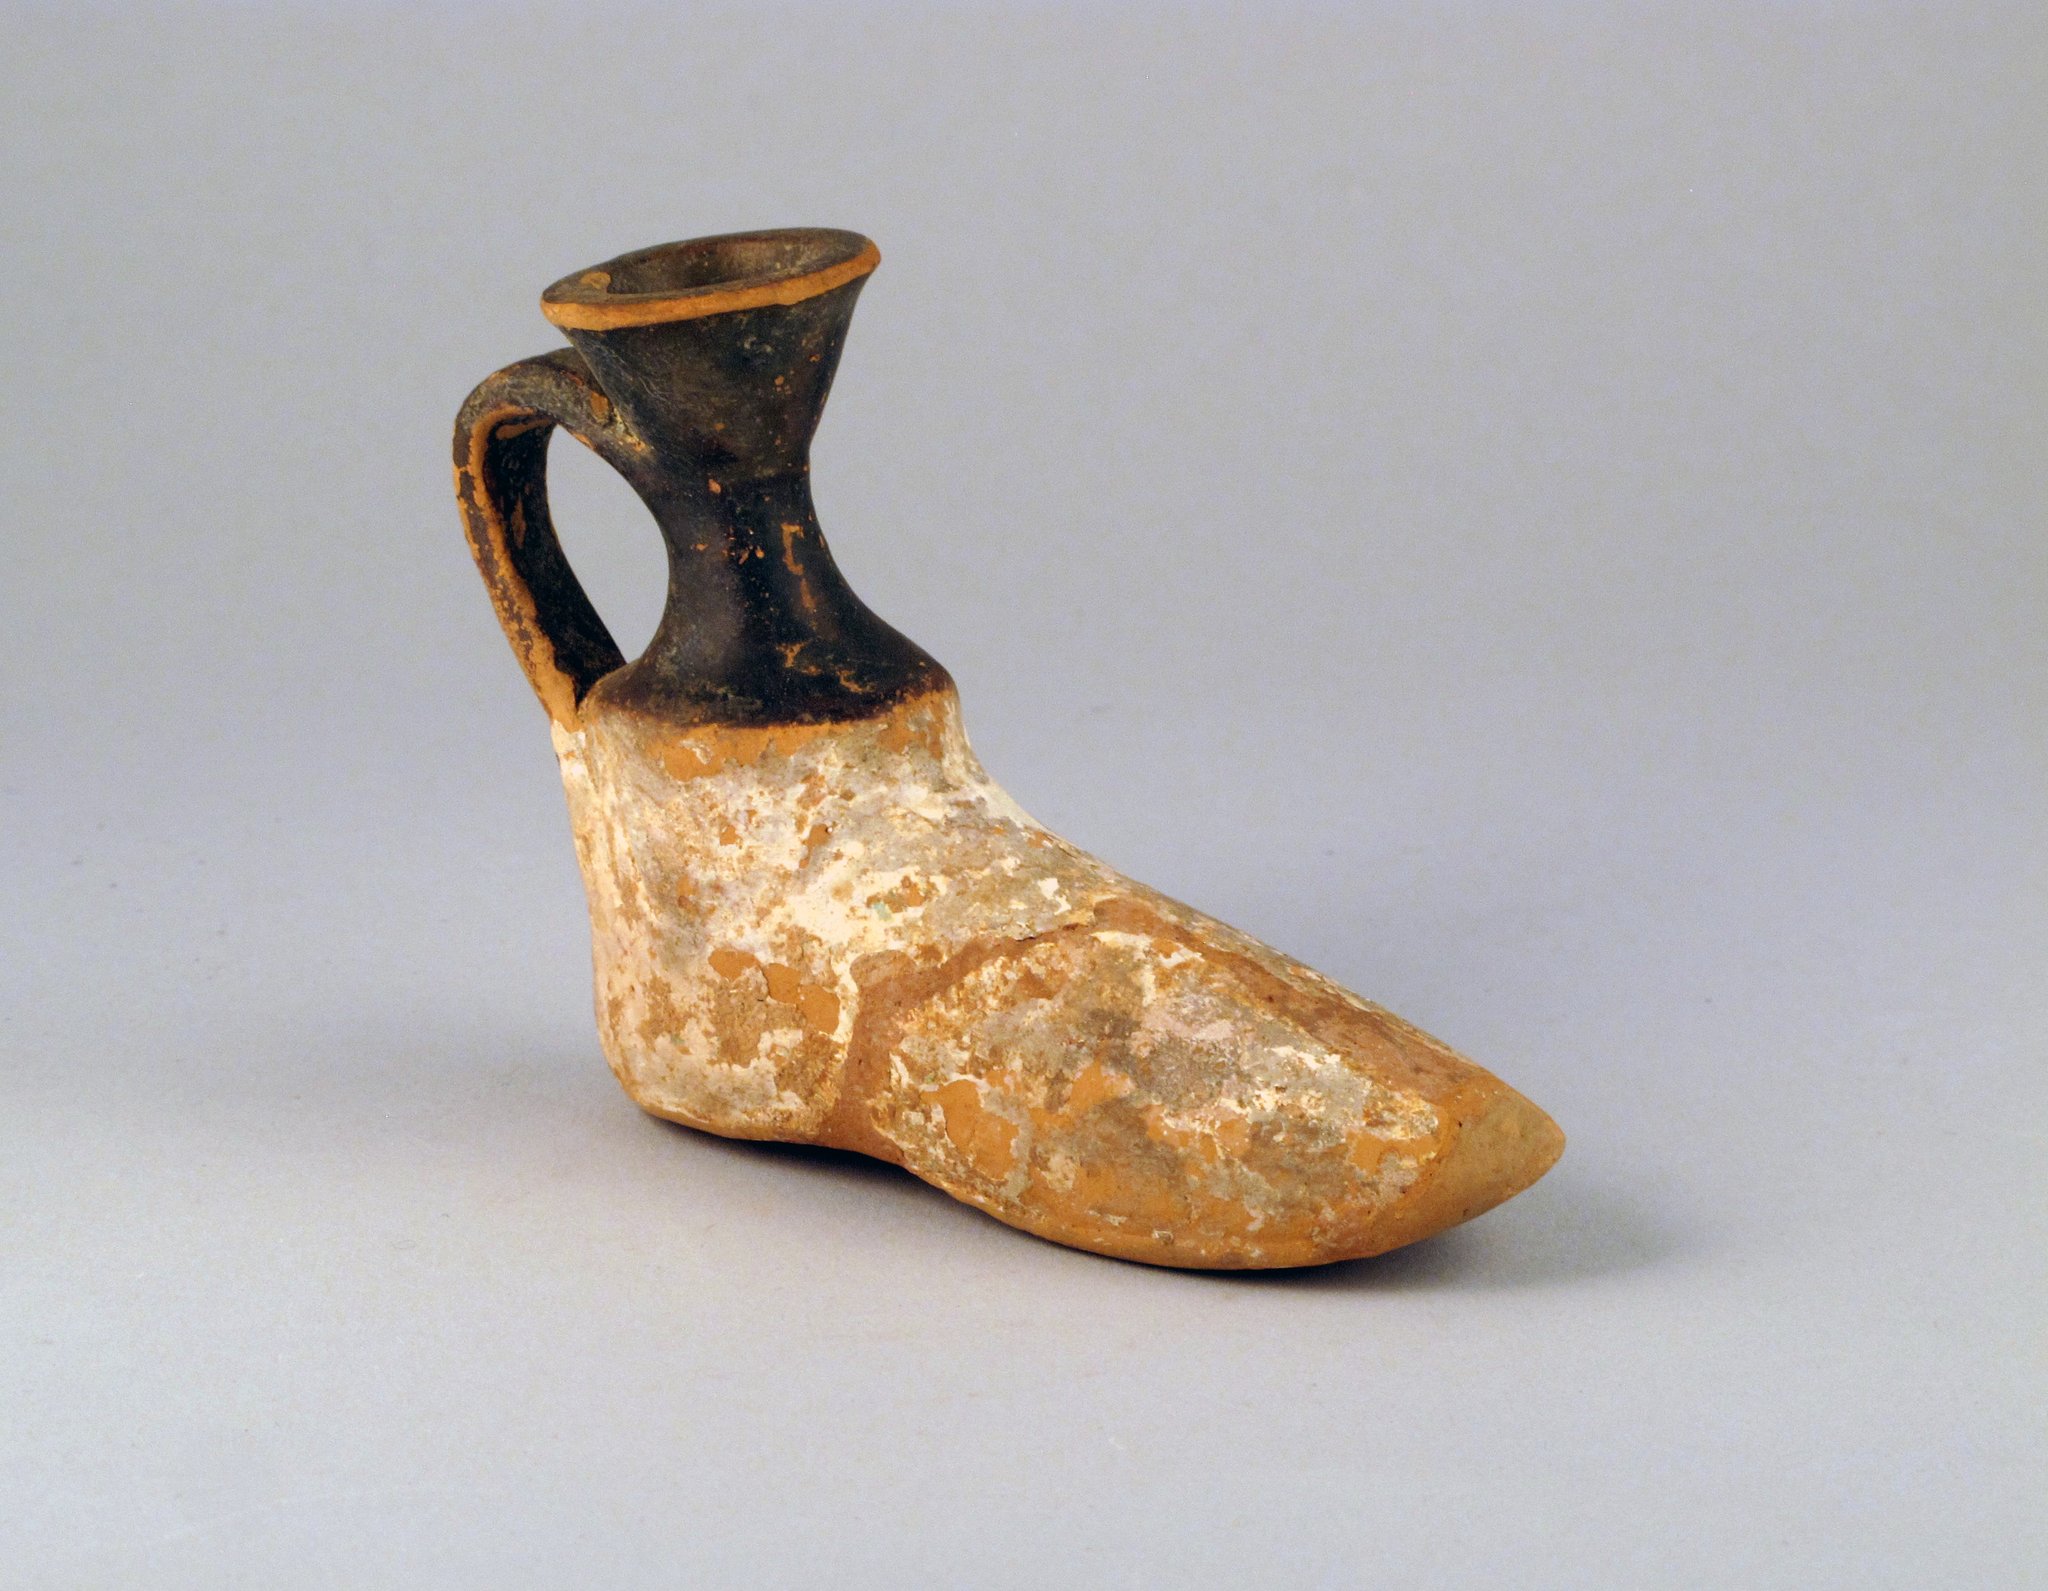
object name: aryballos in the form of a foot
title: Aryballos in the form of a foot with shoe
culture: greek, attic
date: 400-301 BCE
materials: terracotta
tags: shoes